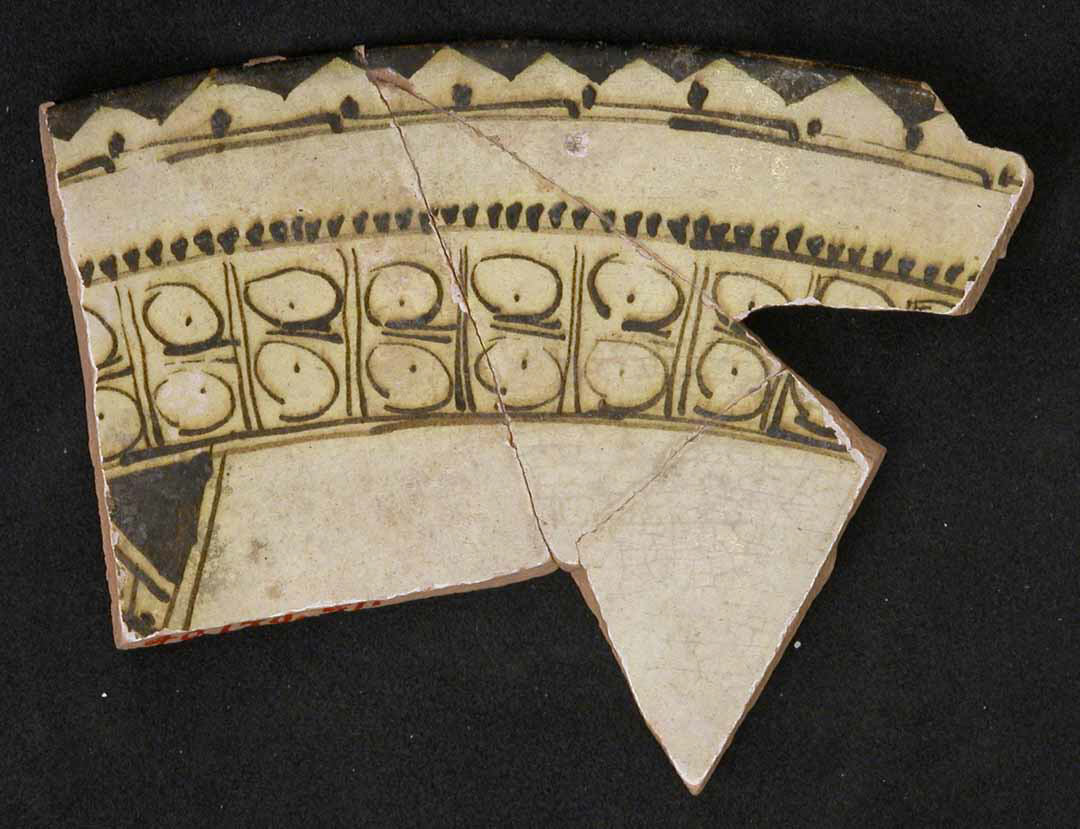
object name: fragment of a bowl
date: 801-1000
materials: earthenware, glaze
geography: iran